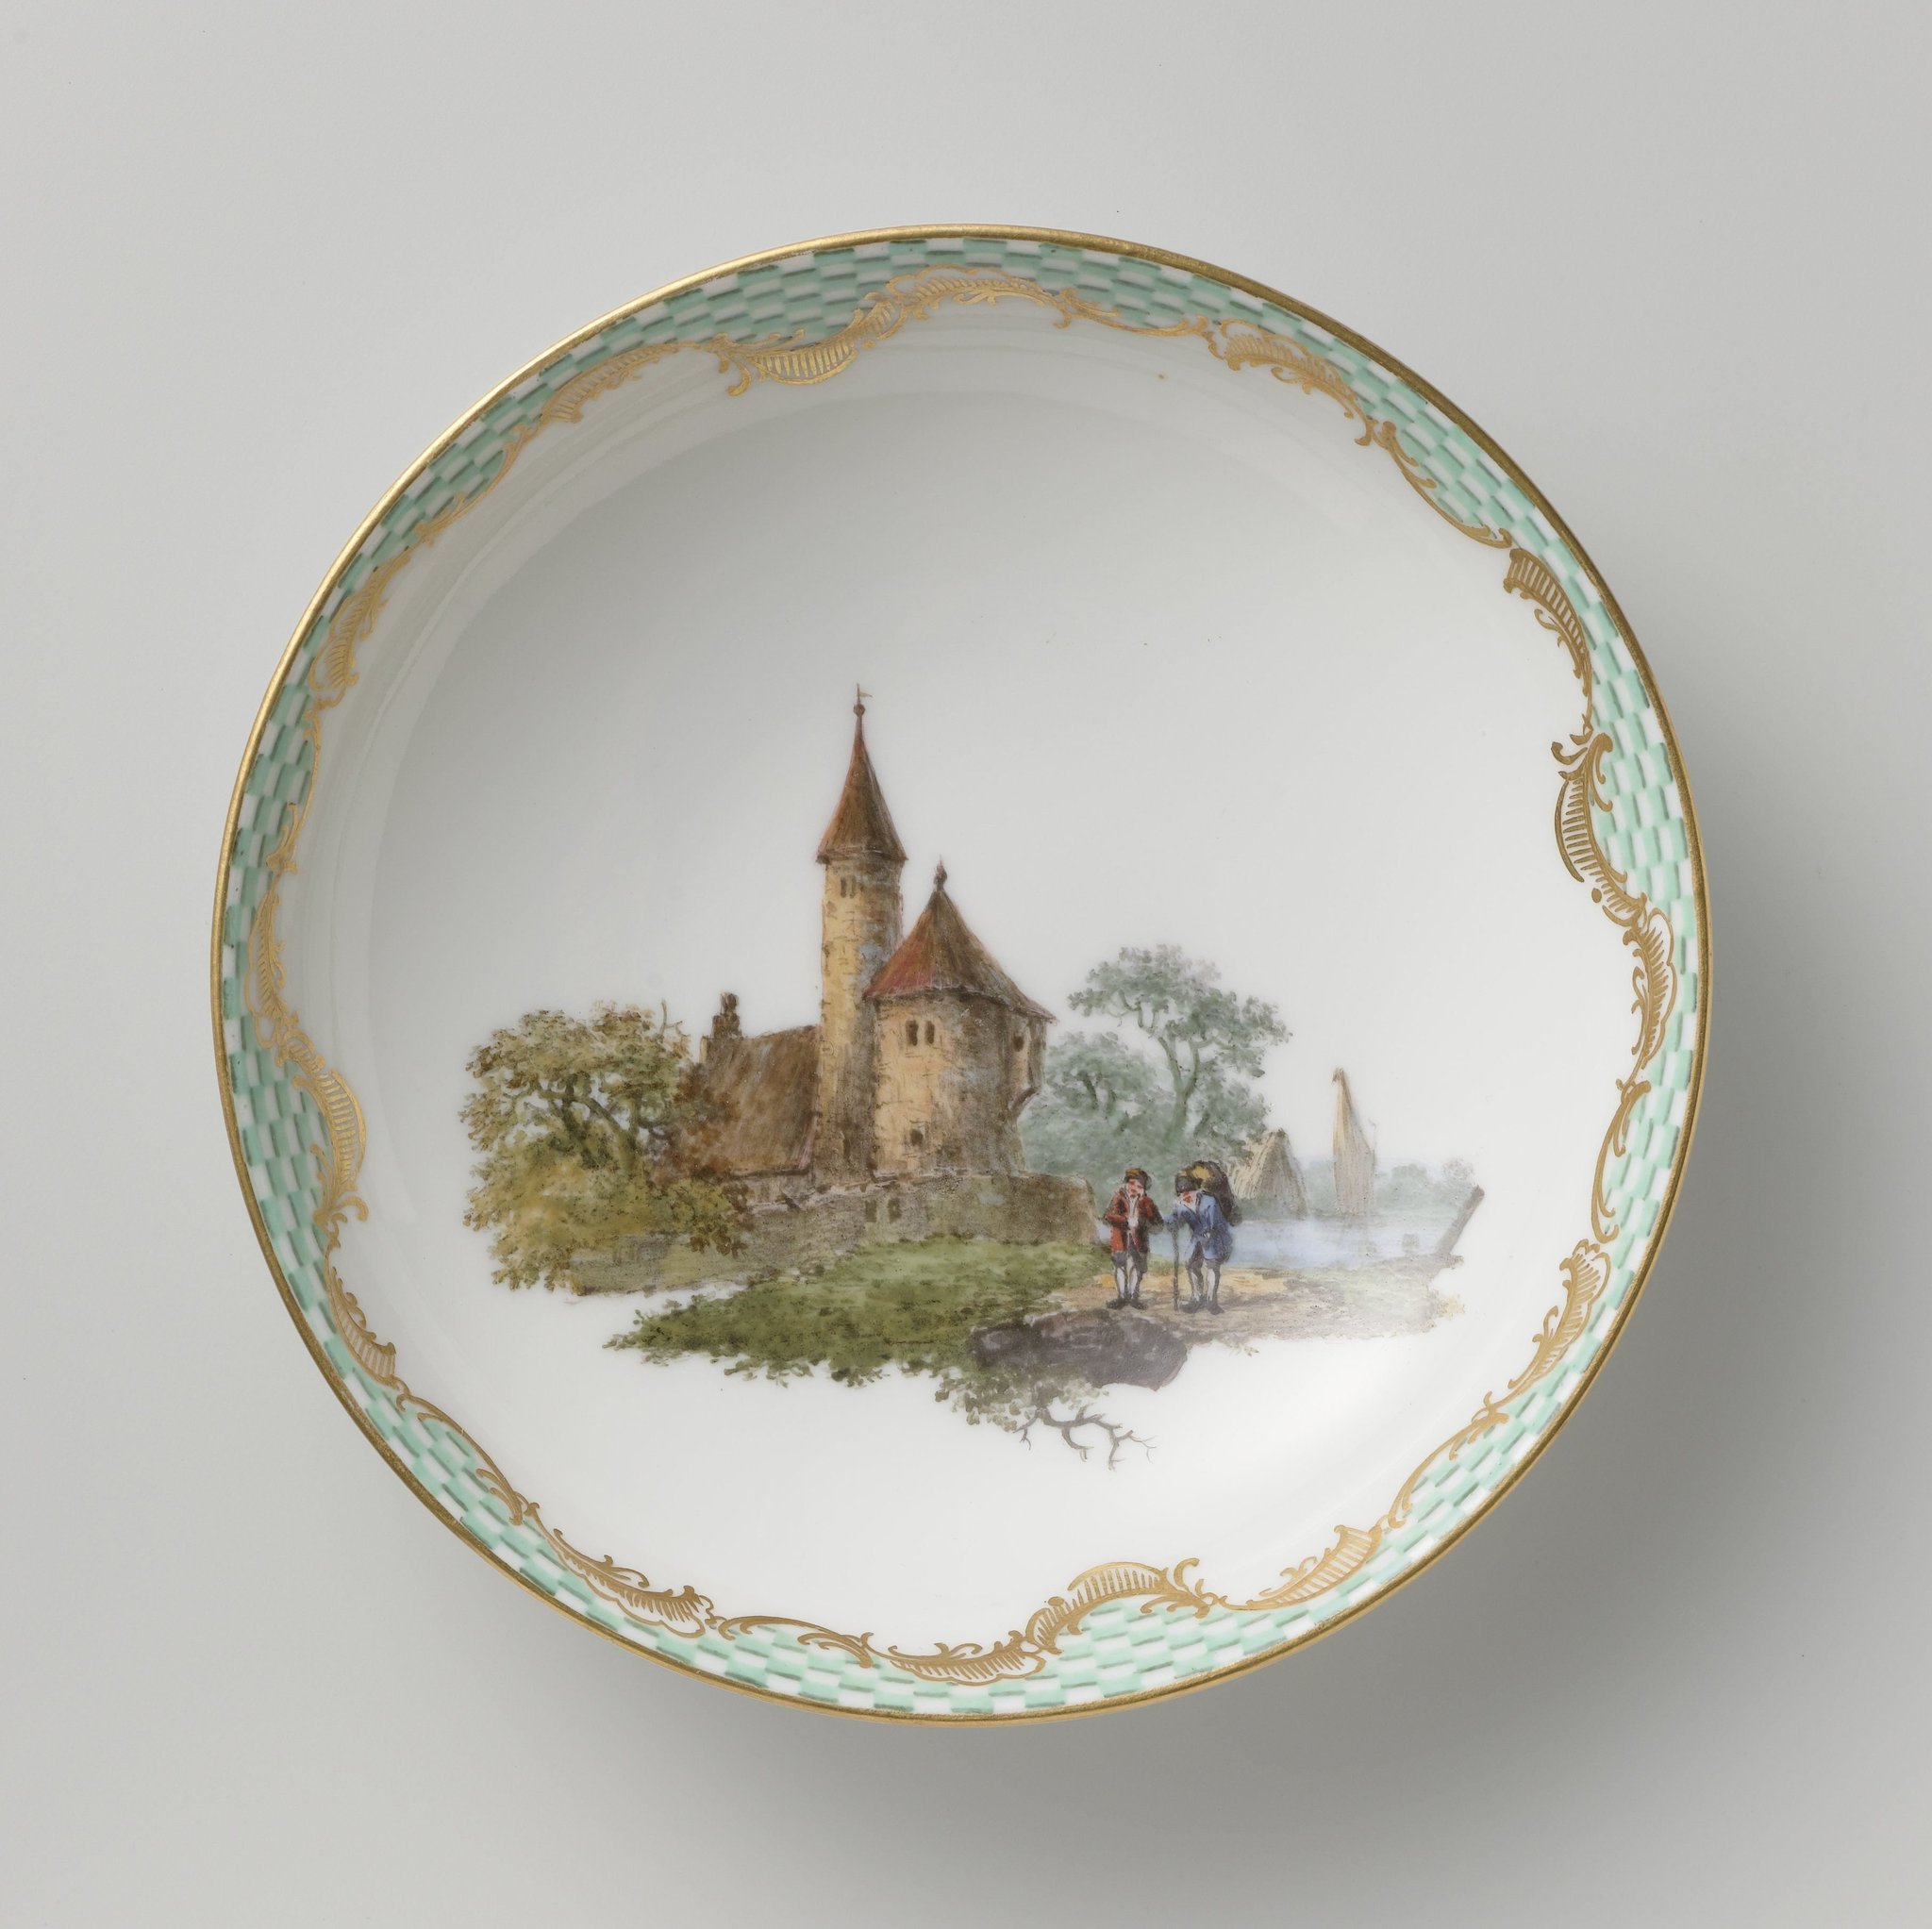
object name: platter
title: Schotel, veelkleurig beschilderd met een landschap met figuren.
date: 1777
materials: porcelain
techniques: painted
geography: meissen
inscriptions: factory mark, mold mark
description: Ronde schotel van beschilderd porselein. De schotel is beschilderd met landschappen waarin figuren en langs de rand een brede strook groen vlechtwerk. De schotel is gemerkt.